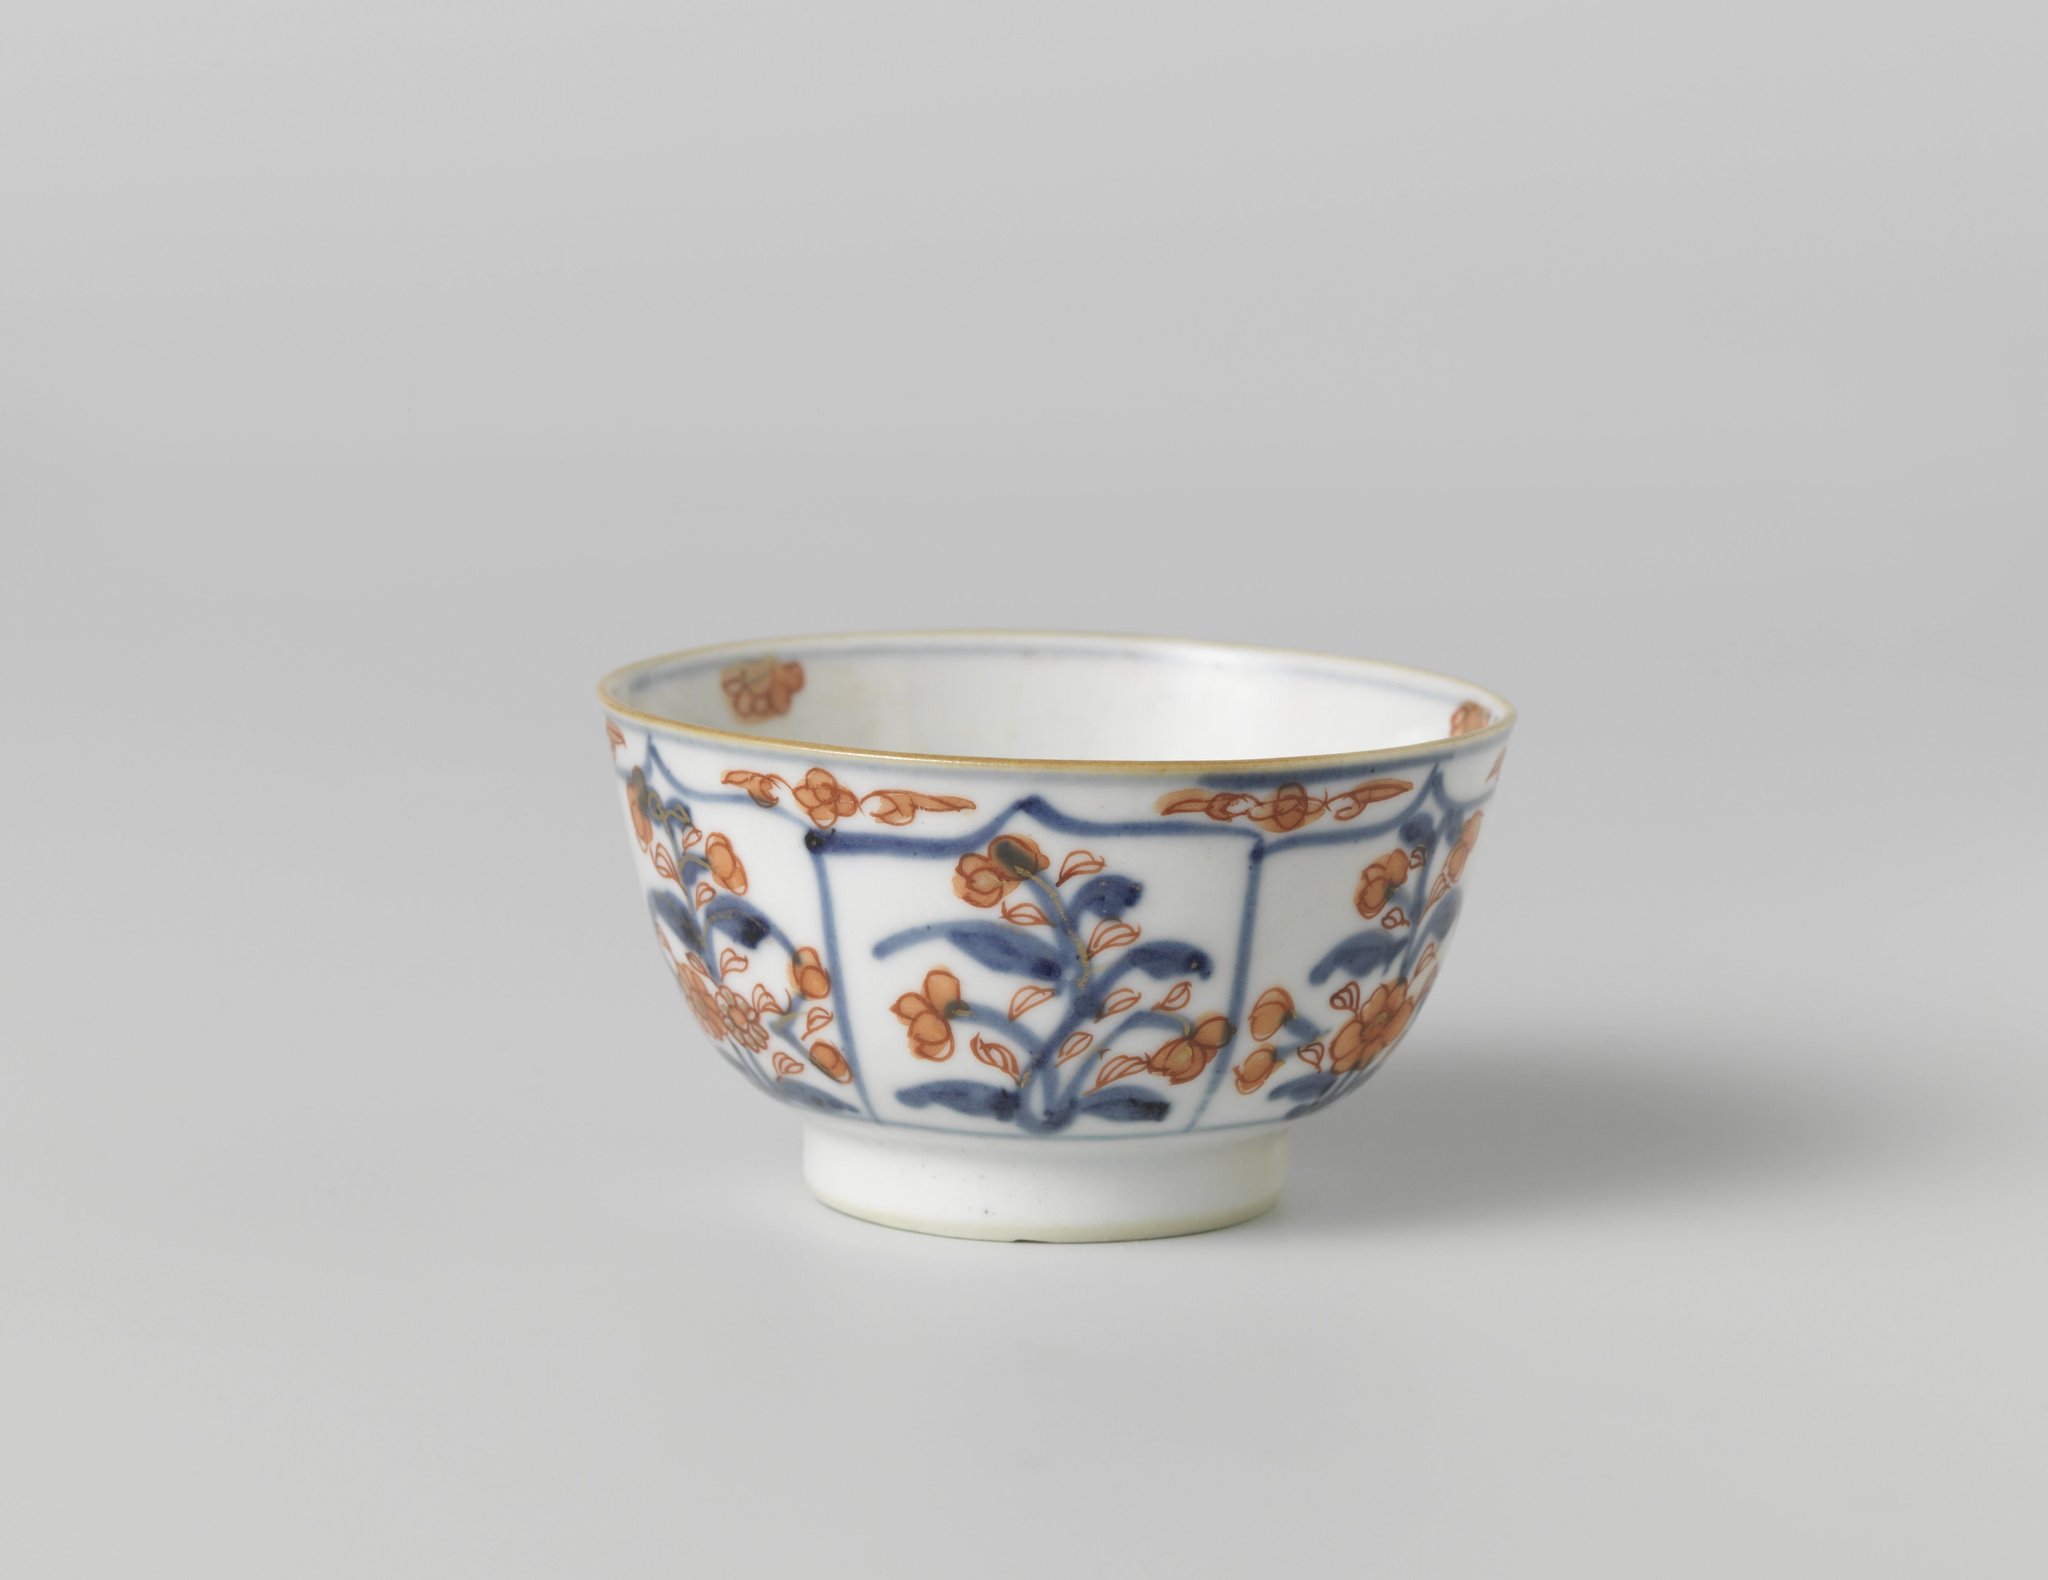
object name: kop en schotel, kop en schotel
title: Cup with petal-shaped panel around a central medallion, filled with flower sprays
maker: Anonymous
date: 1750-1774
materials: cobalt, glaze, gold, paint, porcelain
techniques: firing, gilding, turning, vitrification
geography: china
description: Imari. Beschilderd met vakken waarin takjes in blauw, rood en goud.